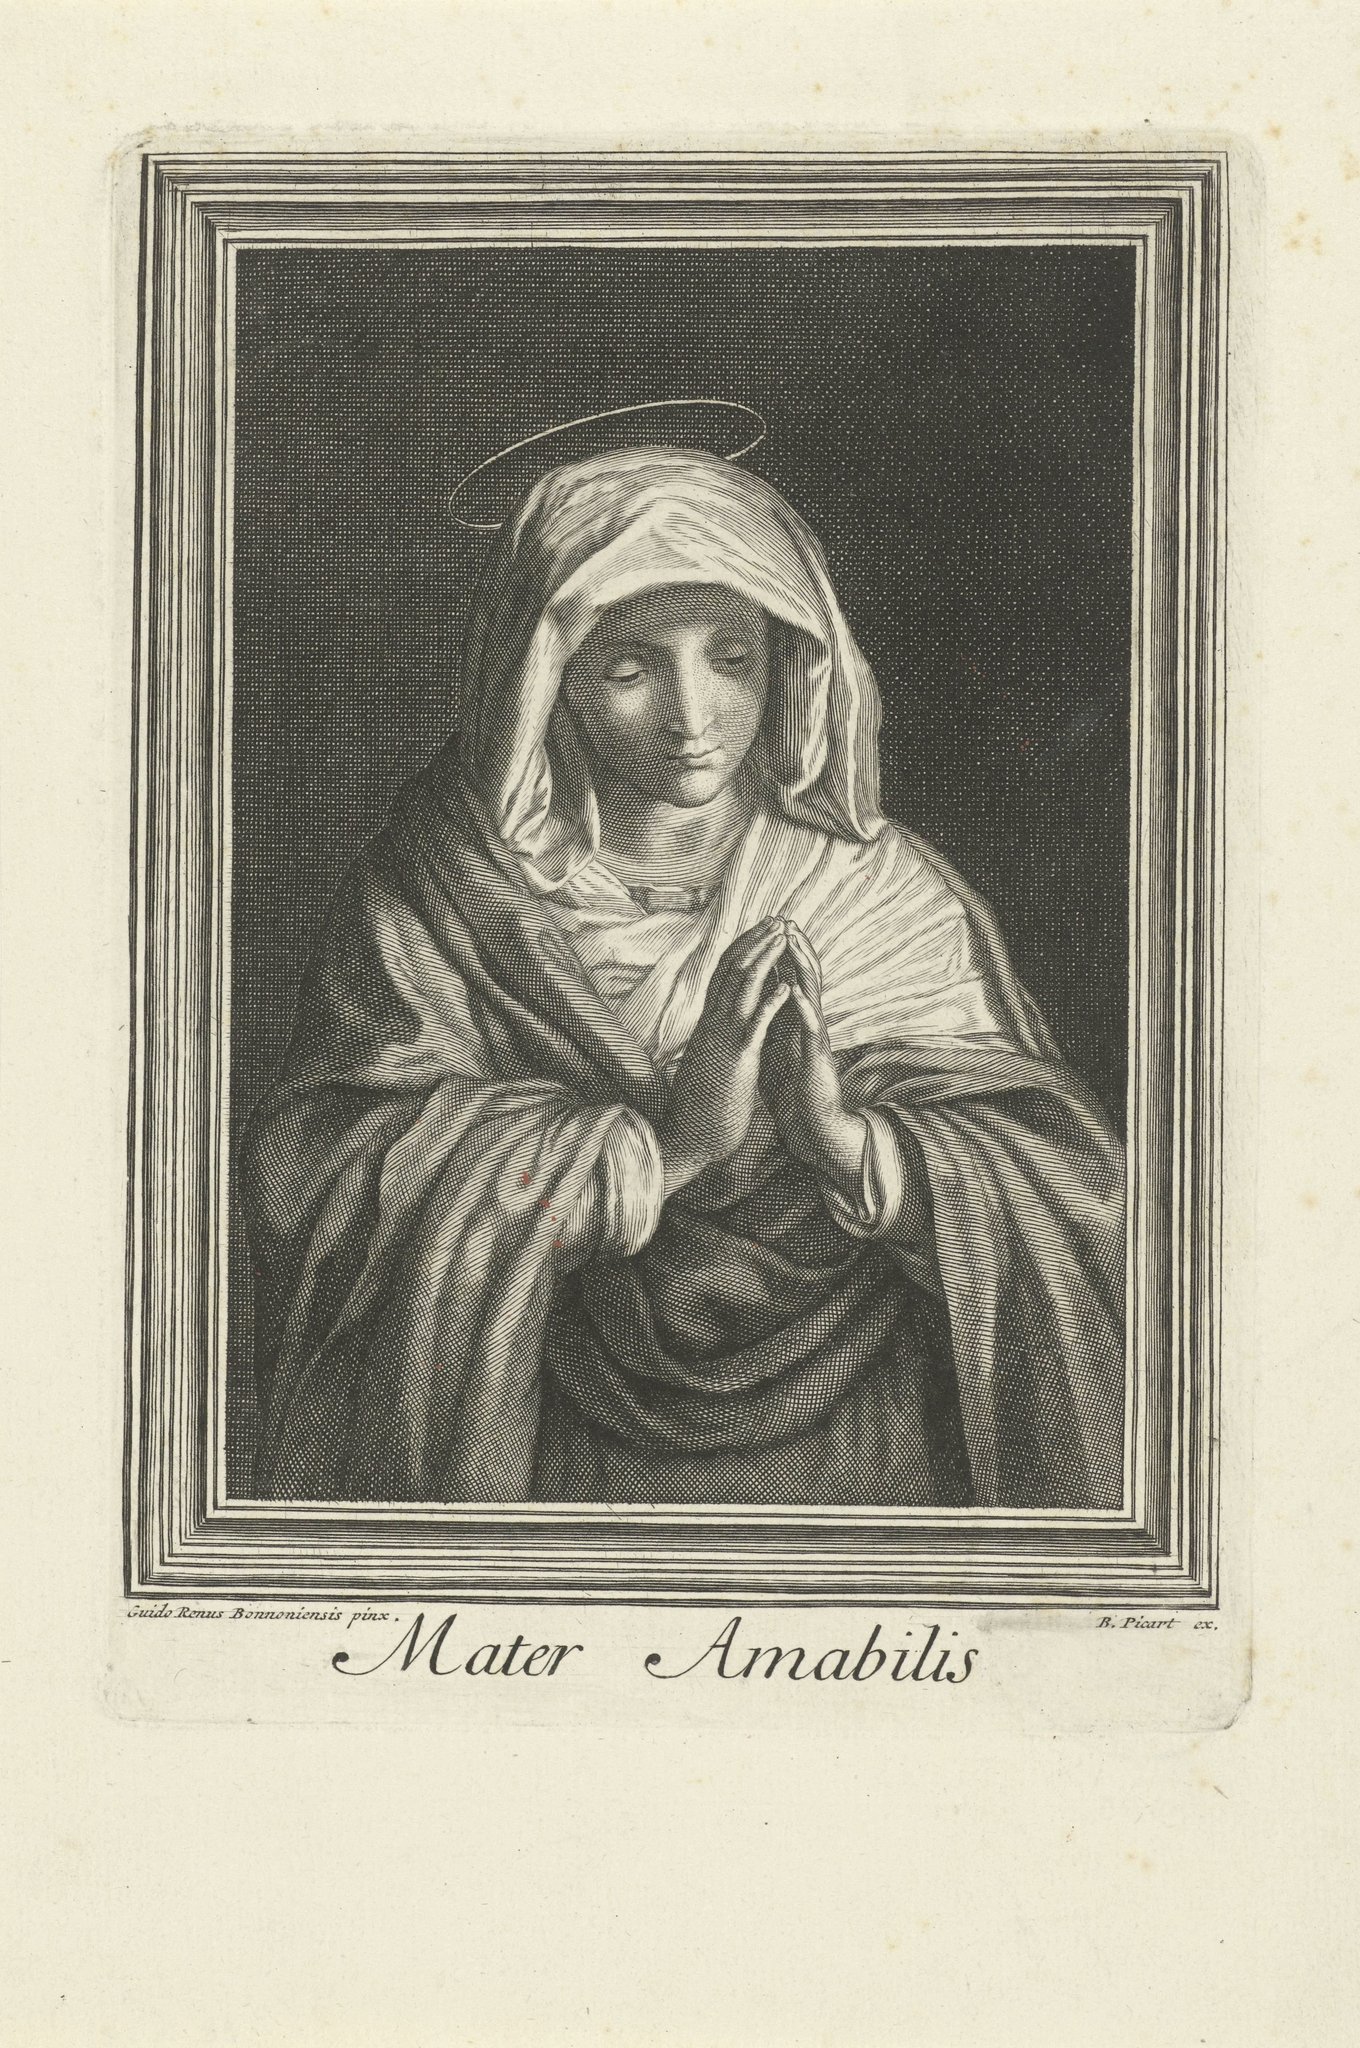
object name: print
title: Mater Amabilis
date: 1683-1733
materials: paper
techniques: engraving, etching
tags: the virgin mary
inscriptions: collector's mark: Lugt 240